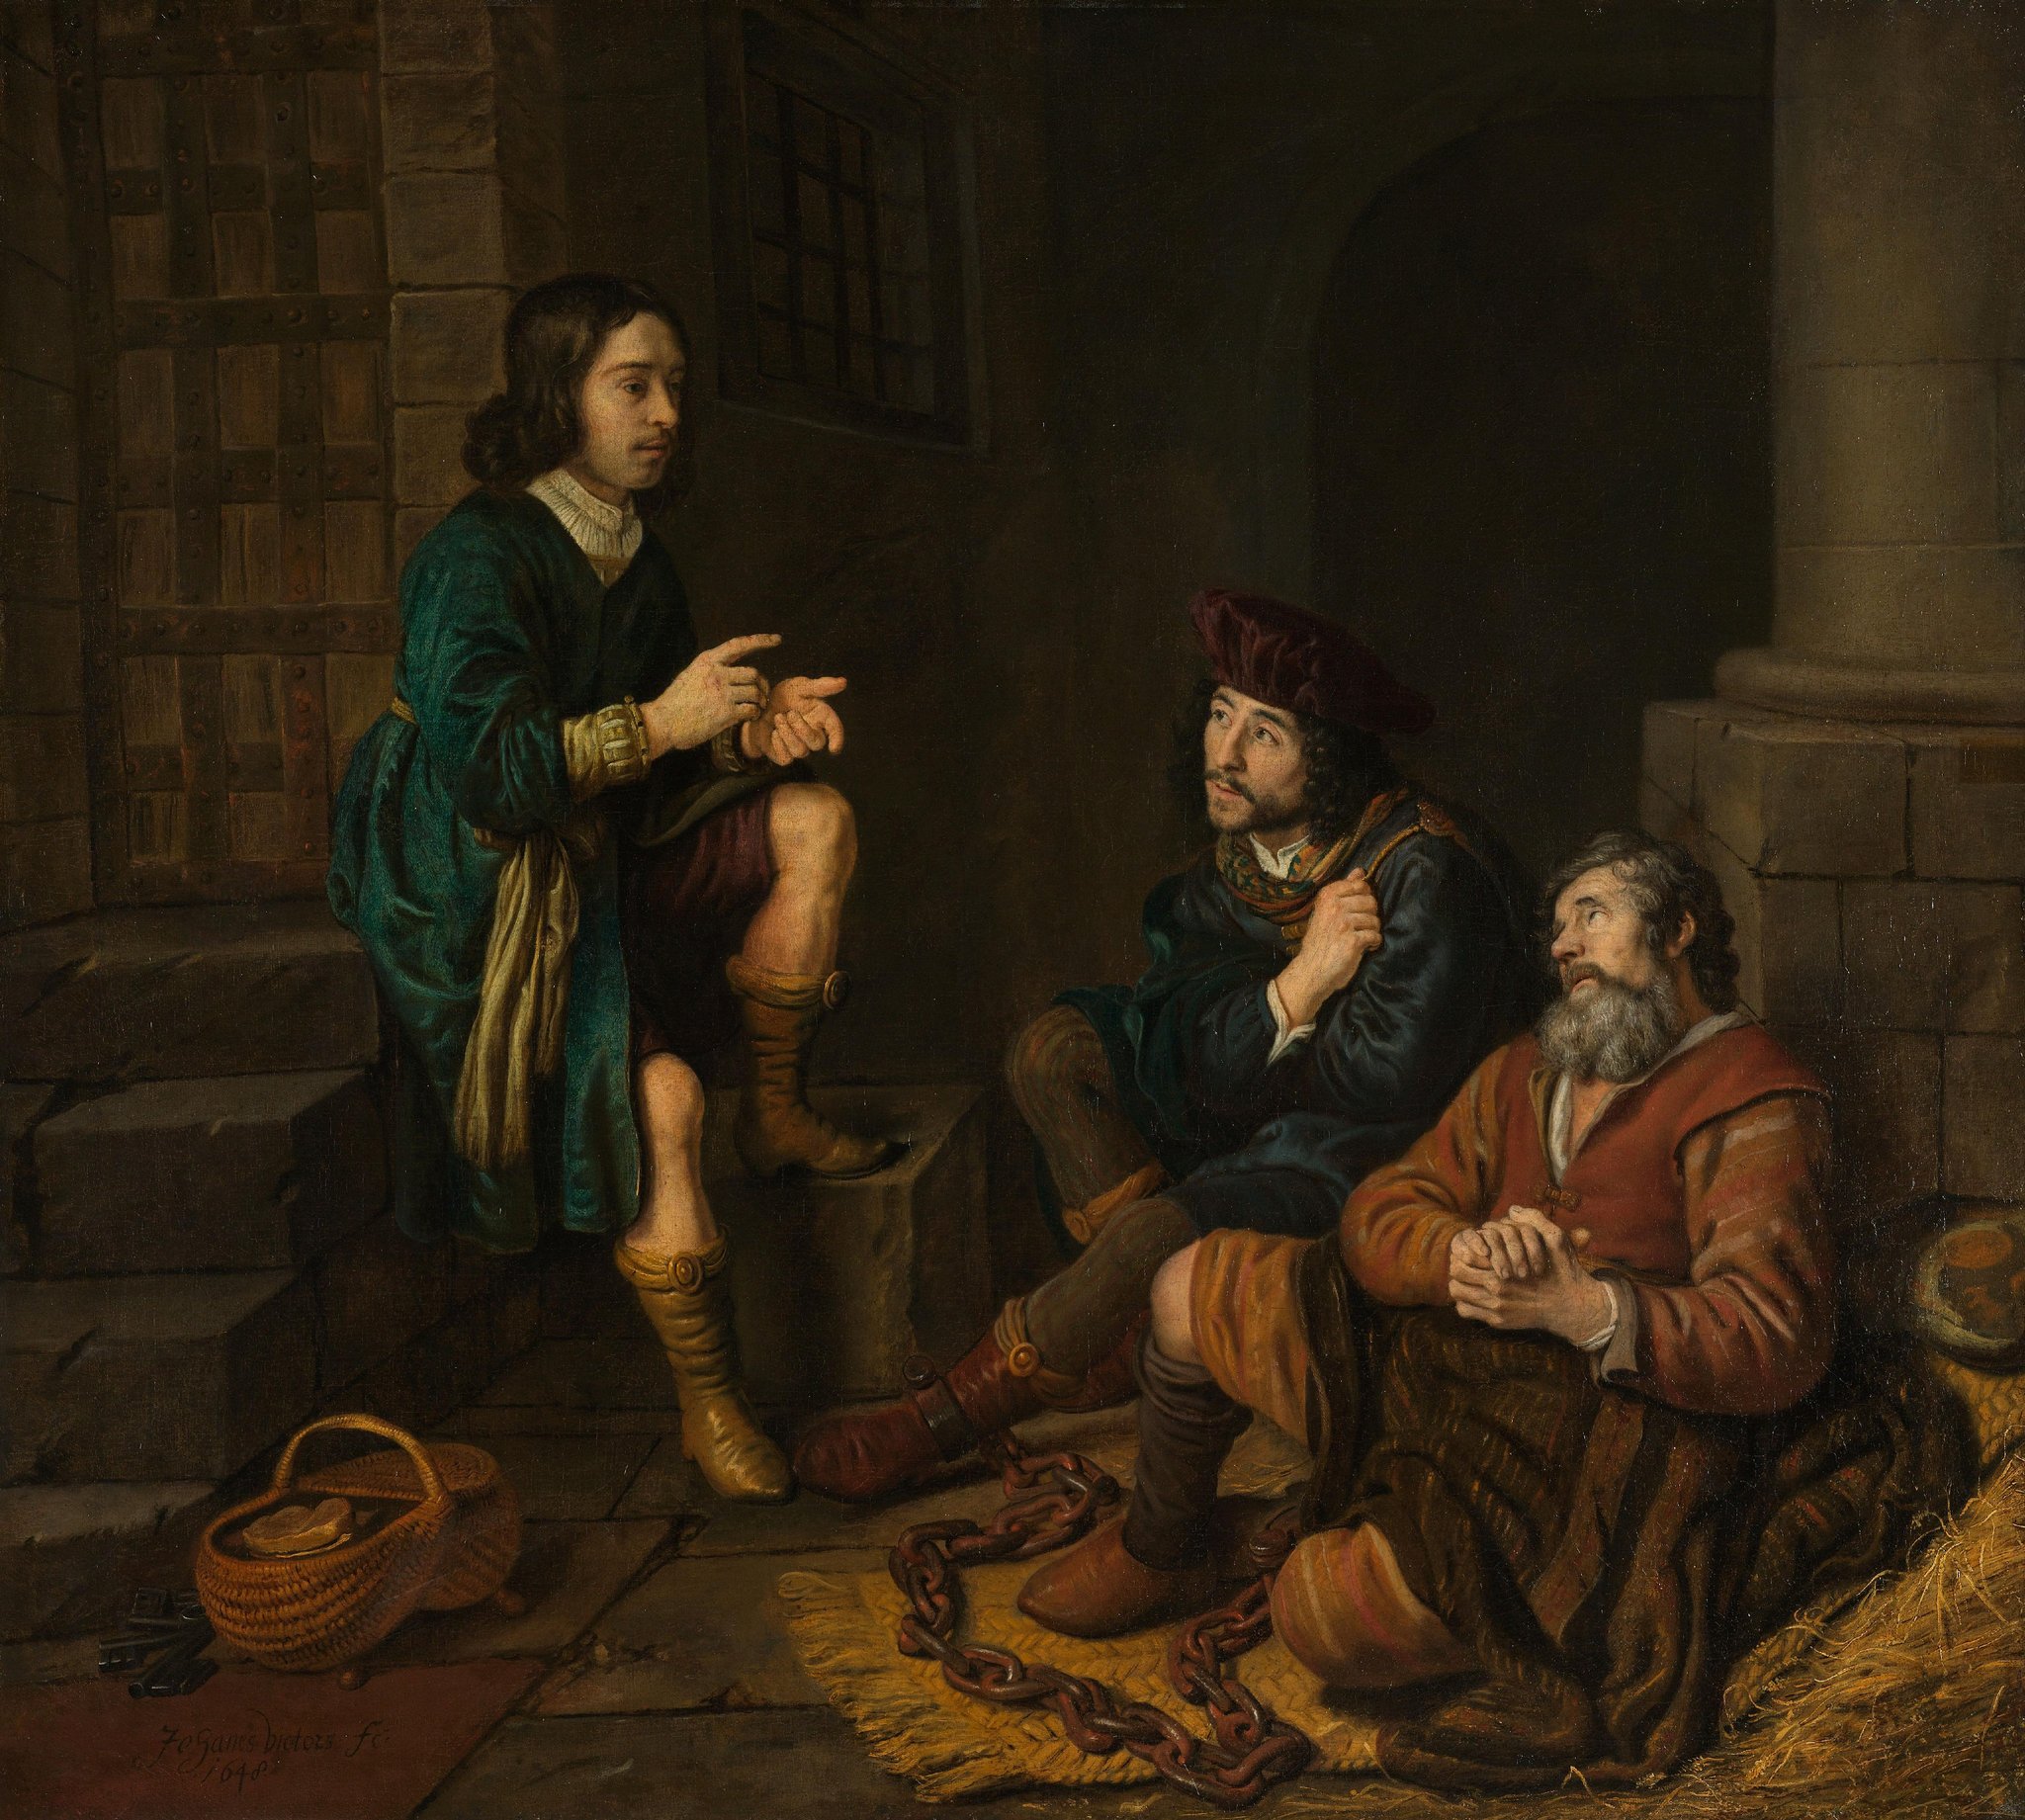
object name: painting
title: Joseph Interprets the Dreams of the Baker and the Butler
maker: jan victors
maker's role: painter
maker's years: 1619-1676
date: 1648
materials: canvas, oil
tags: joseph interpreting the dreams of the butler and the baker (the two dreams combined)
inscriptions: signature and date: ‘Johanes Victors. fe. 1648’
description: Jozef legt de bakker en de schenker hun dromen uit. In de gevangenis zit Jozef links op een stenen trap, de bakker en de schenker liggen rechts geketend op de grond.